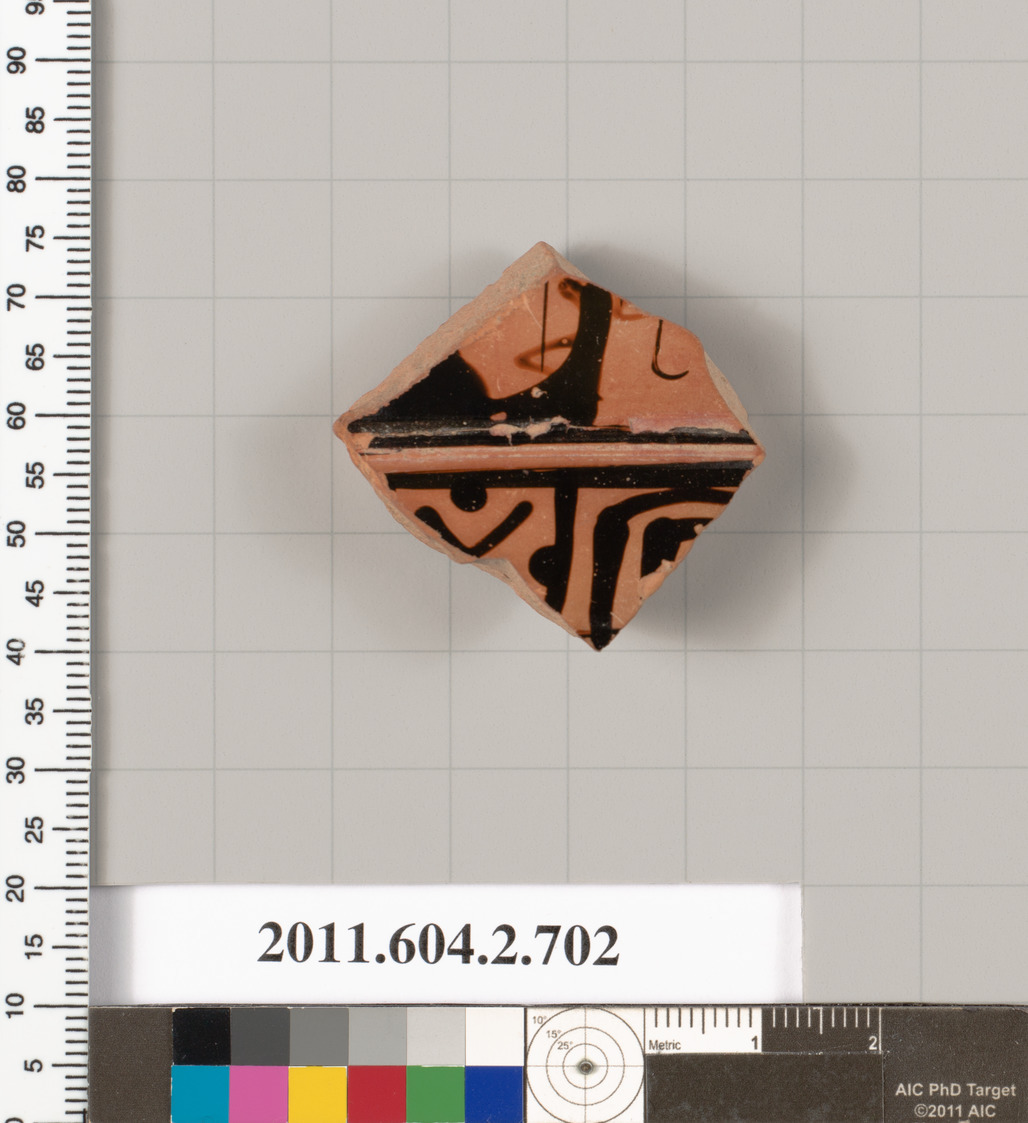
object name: calyx krater fragment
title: Terracotta fragment of a calyx-krater (bowl for mixing wine and water)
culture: greek, attic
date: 450-440 BCE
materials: terracotta